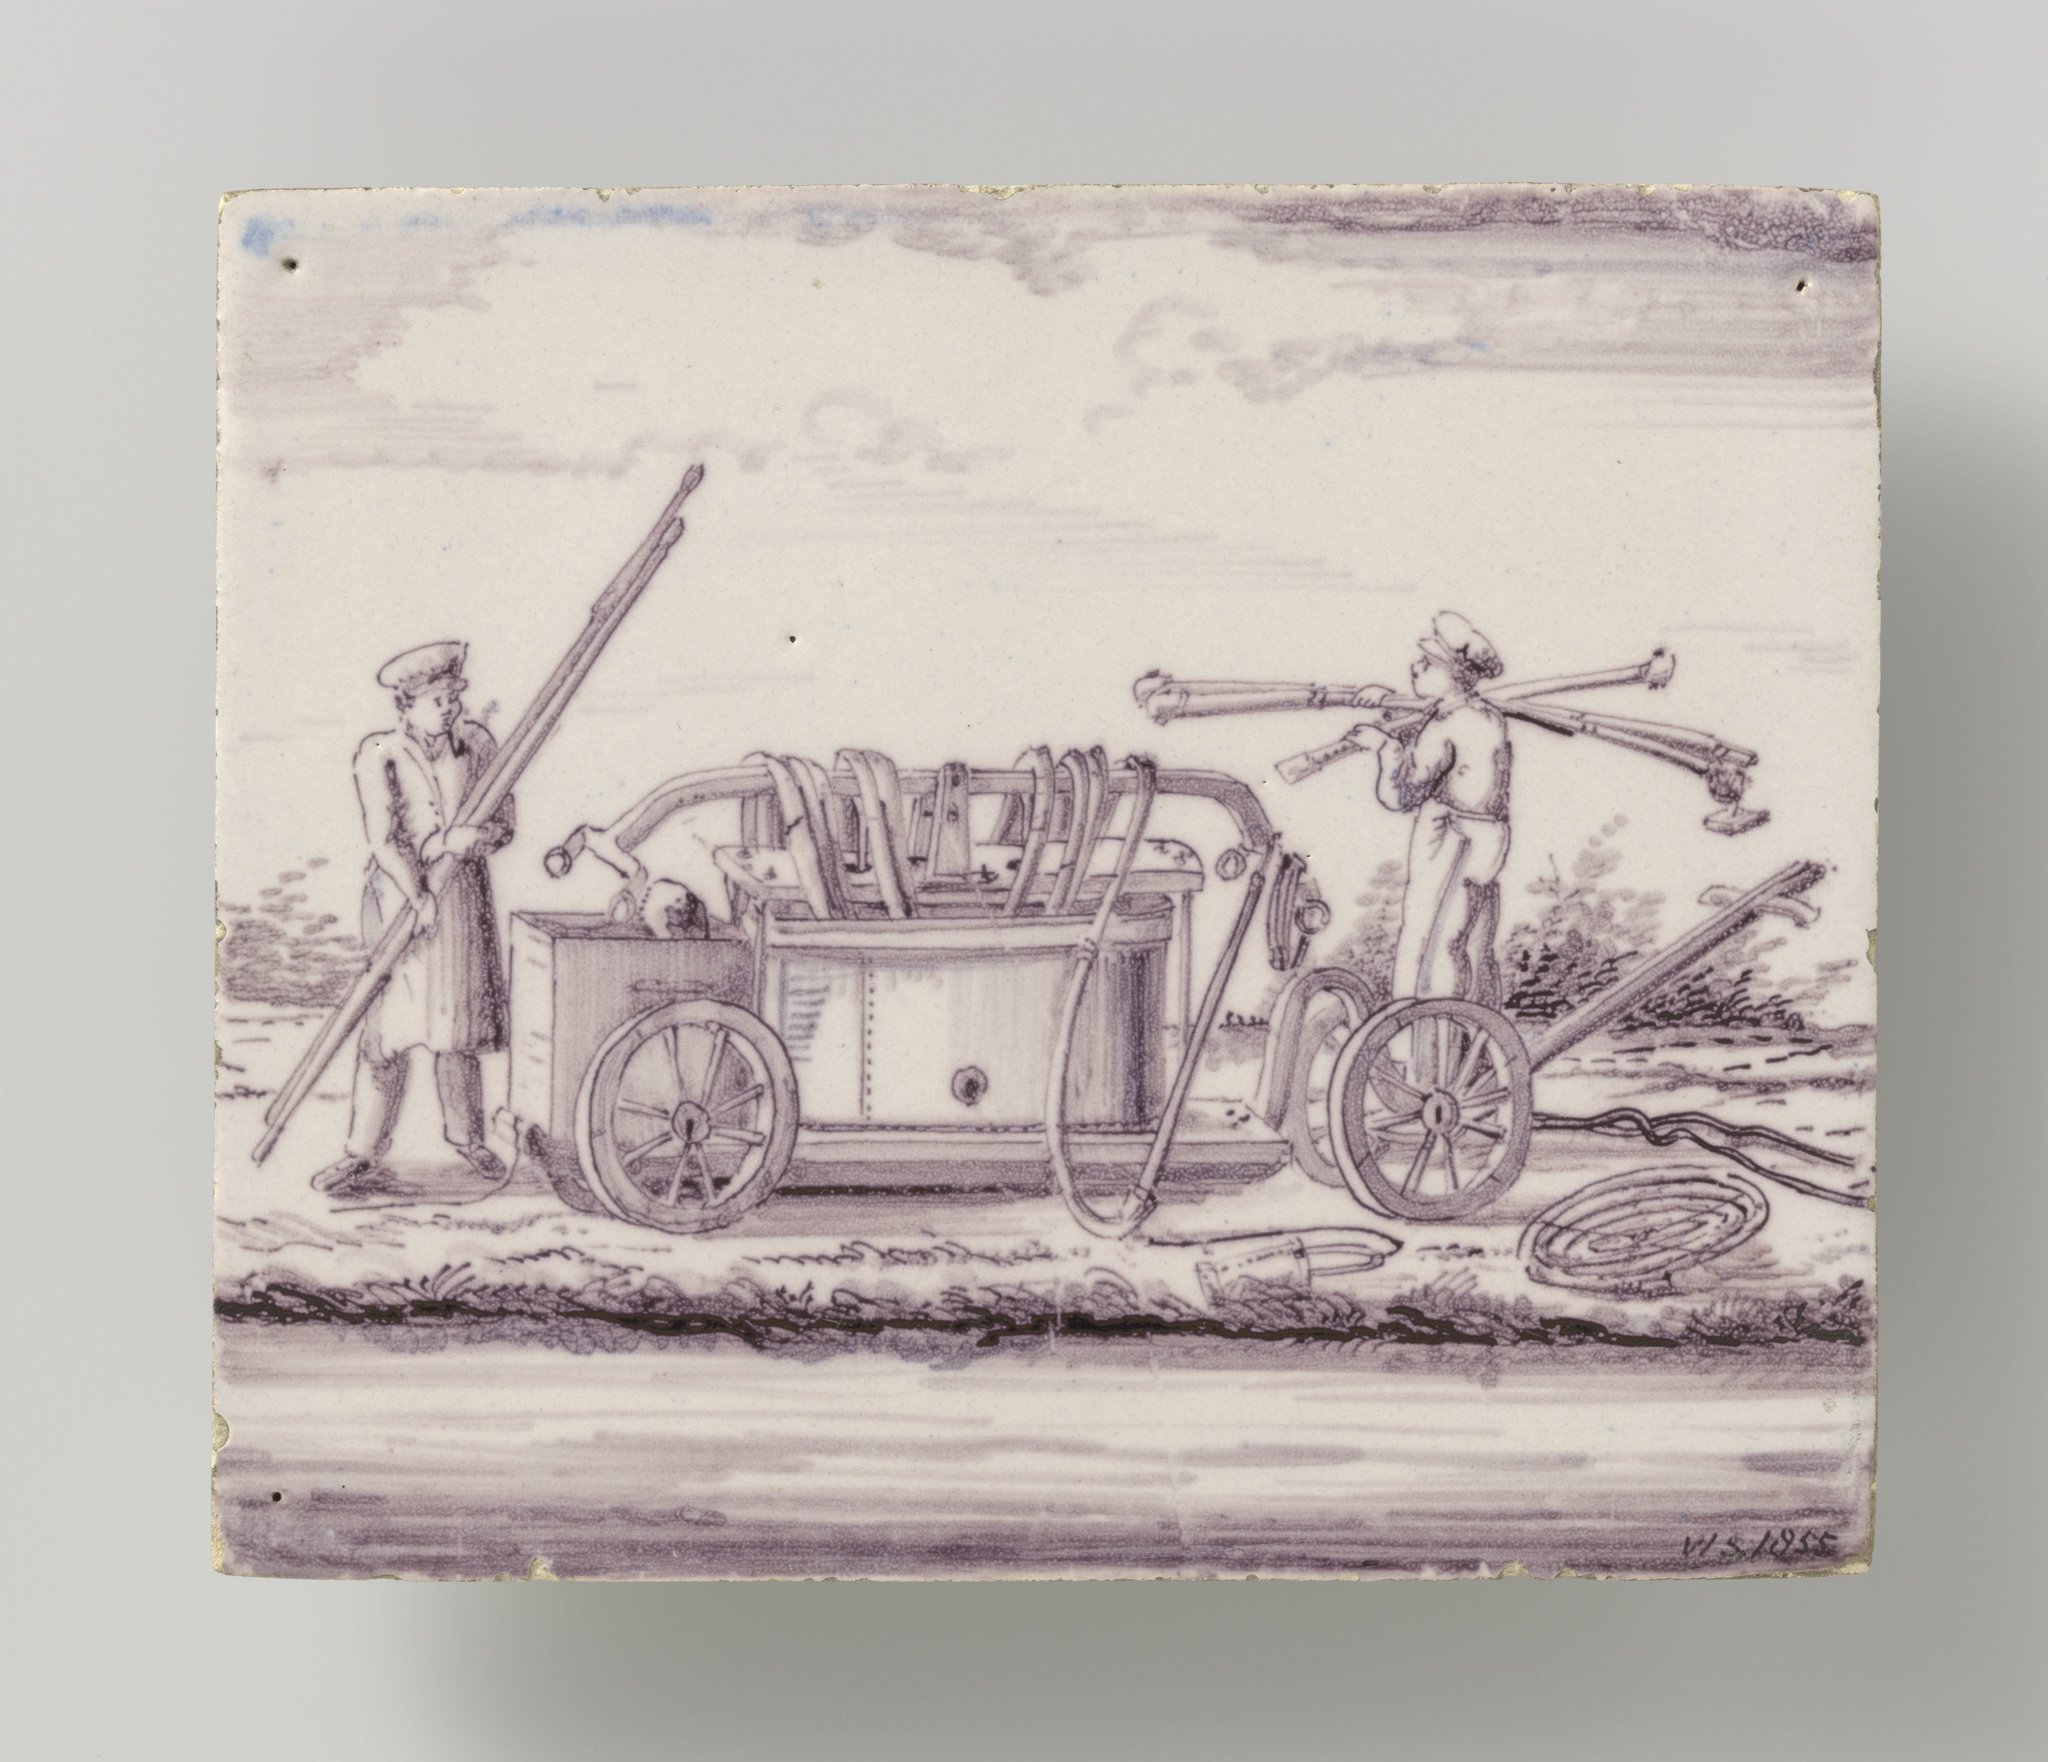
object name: tile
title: Tegel met voorstelling van een brandspuit (?).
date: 1400-1950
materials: earthenware, glaze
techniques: maiolica